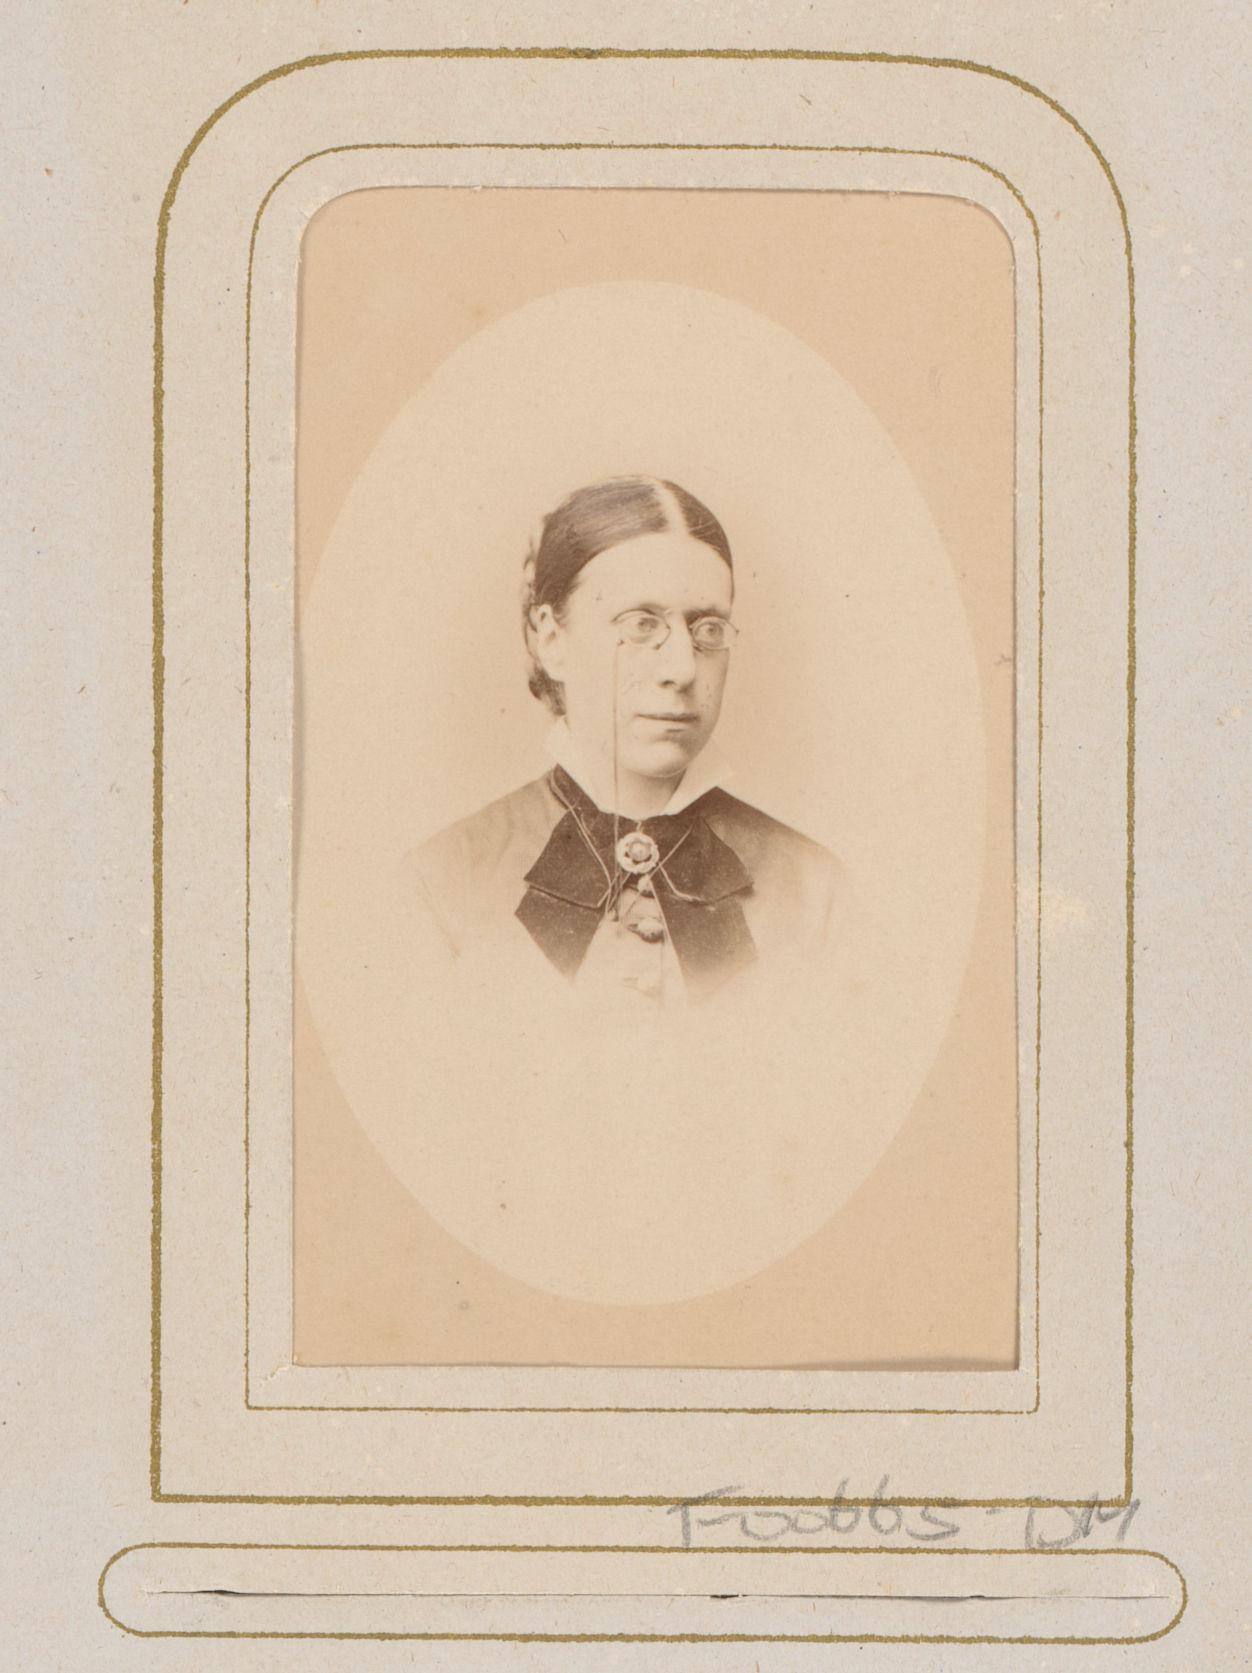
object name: carte de visite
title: Portret van een vrouw met bril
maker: christiaan martinus jan hermelink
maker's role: fotograaf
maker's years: 1840-1933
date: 1867-1885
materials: cardboard, photographic support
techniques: albumen print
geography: the hague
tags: eyeglasses, spectacles, historical persons - bb - woman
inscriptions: inscription: ‘C.M.J. Hermelink/ 62. Denneweg/ La Haye’